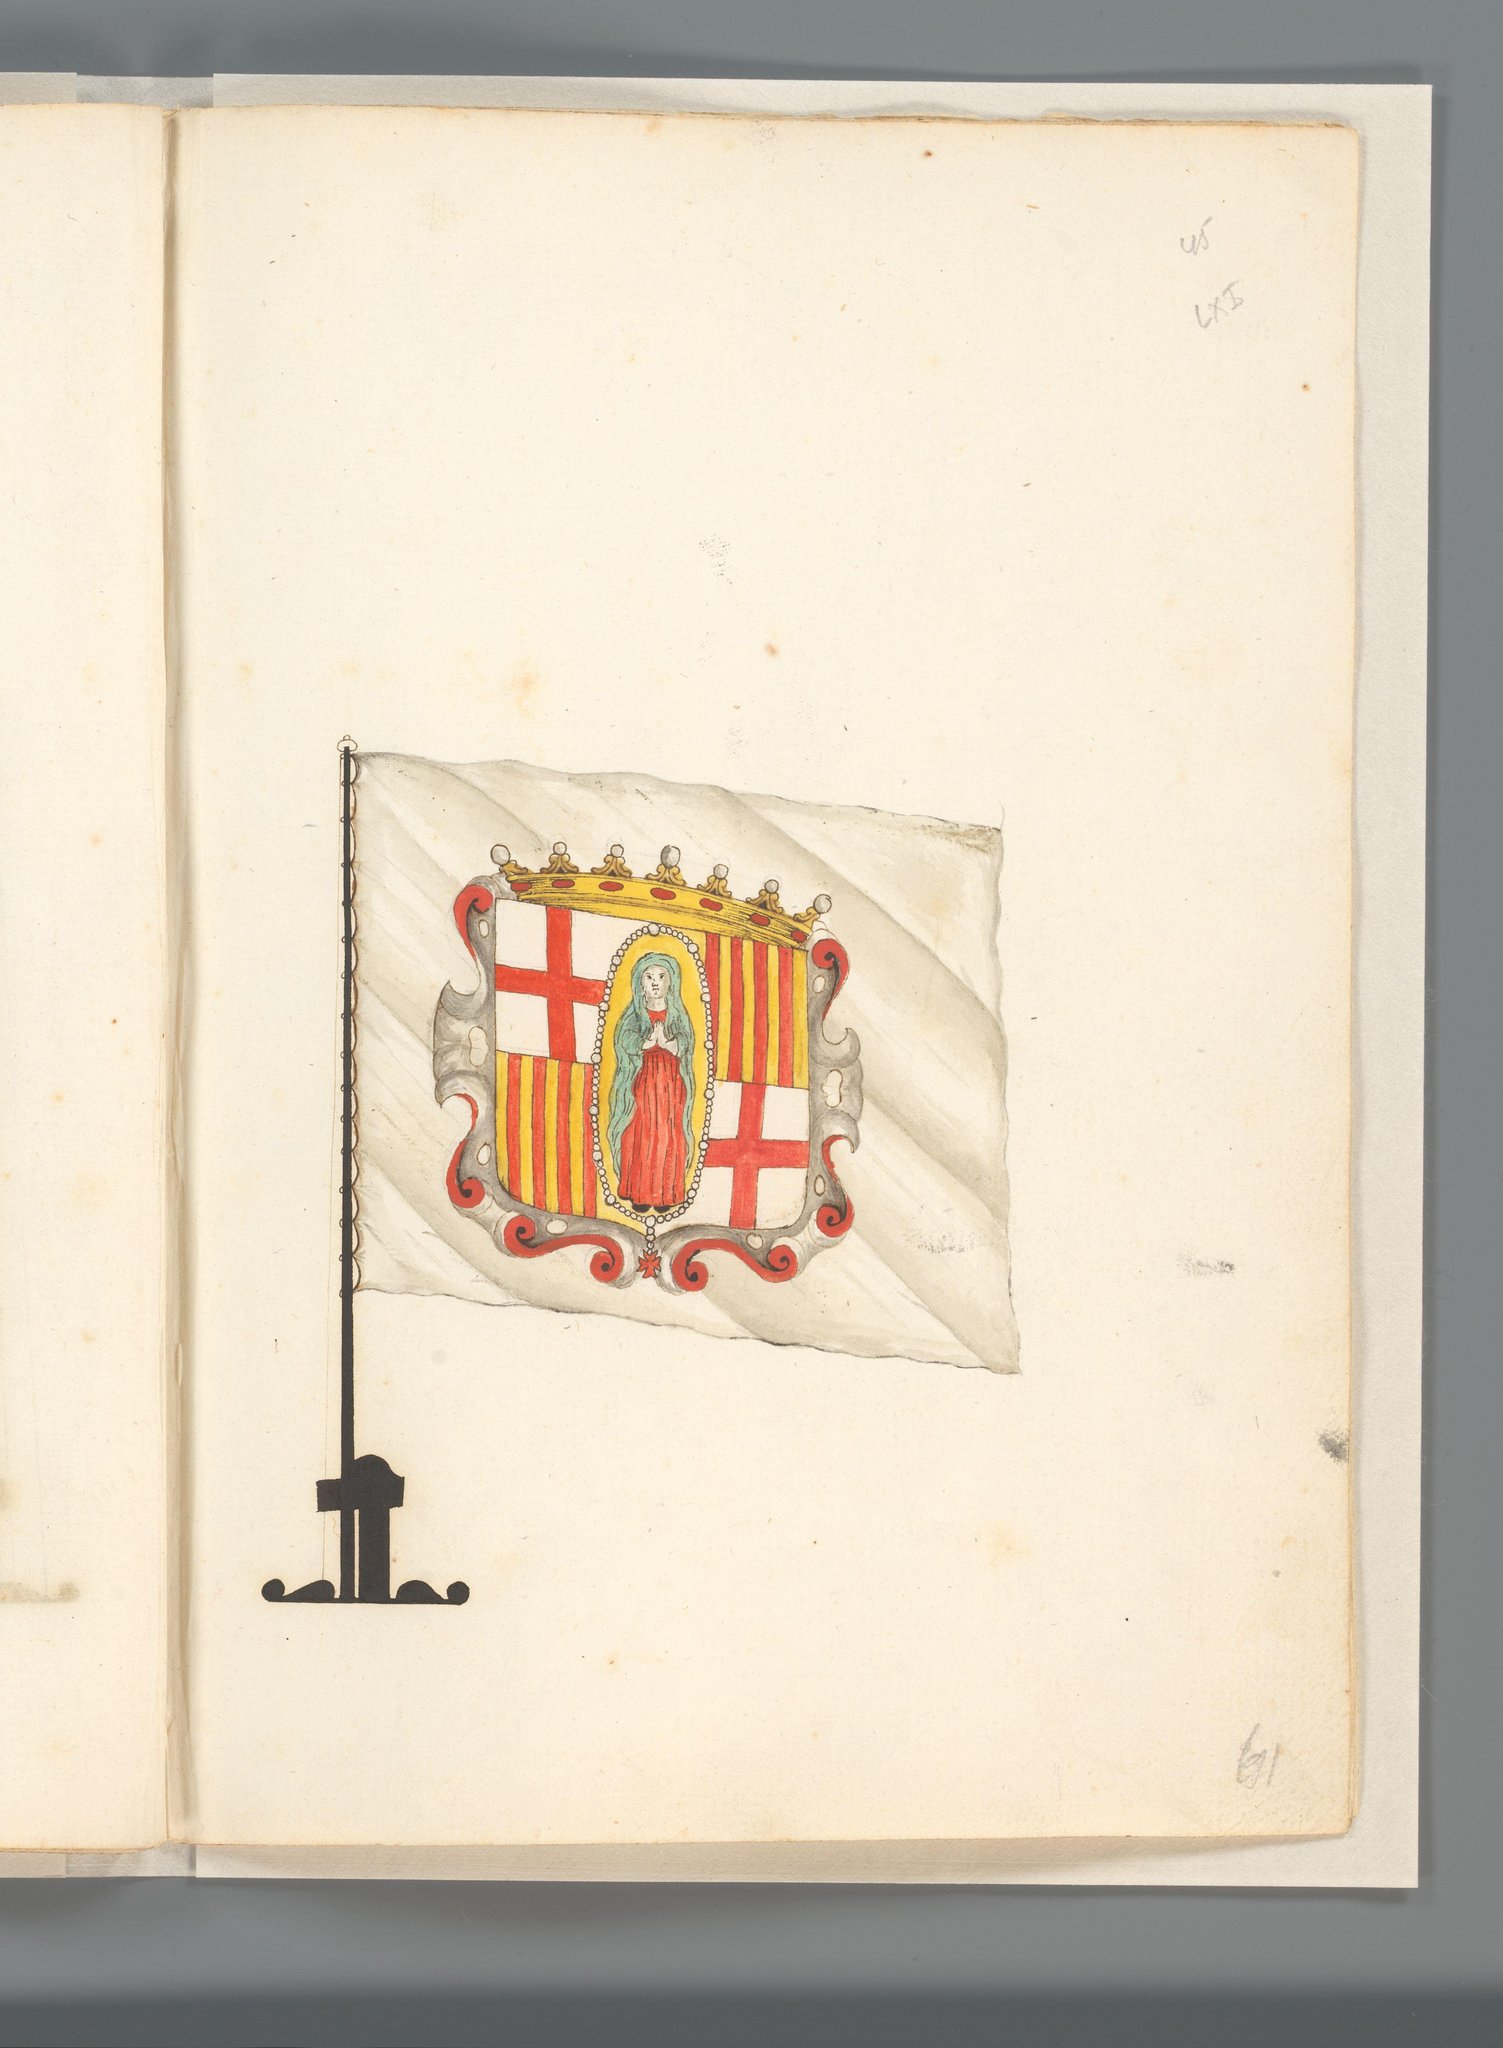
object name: drawing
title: Vlag van Barcelona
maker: Anonymous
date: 1667-1670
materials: ink, paper, watercolor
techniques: brush, pen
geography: france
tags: flag, colours (as symbol of the state, etc.)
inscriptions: number: ‘45 / LXI / 61’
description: Vlag van Barcelona. Witte vlag waarop het wapen van de stad Barcelona, centraal in een rozenkrans de berschermheilige van de stad Nuestra Señora de Compostella. Het wapen gevat in een cartouche. Vlag op vlaggensteng en mastvoet. Afgebeeld op folio 32r. Onderdeel van een vlaggenboek met vlaggen uit Europa, Noord-Afrika, Nabije en Verre Oosten.